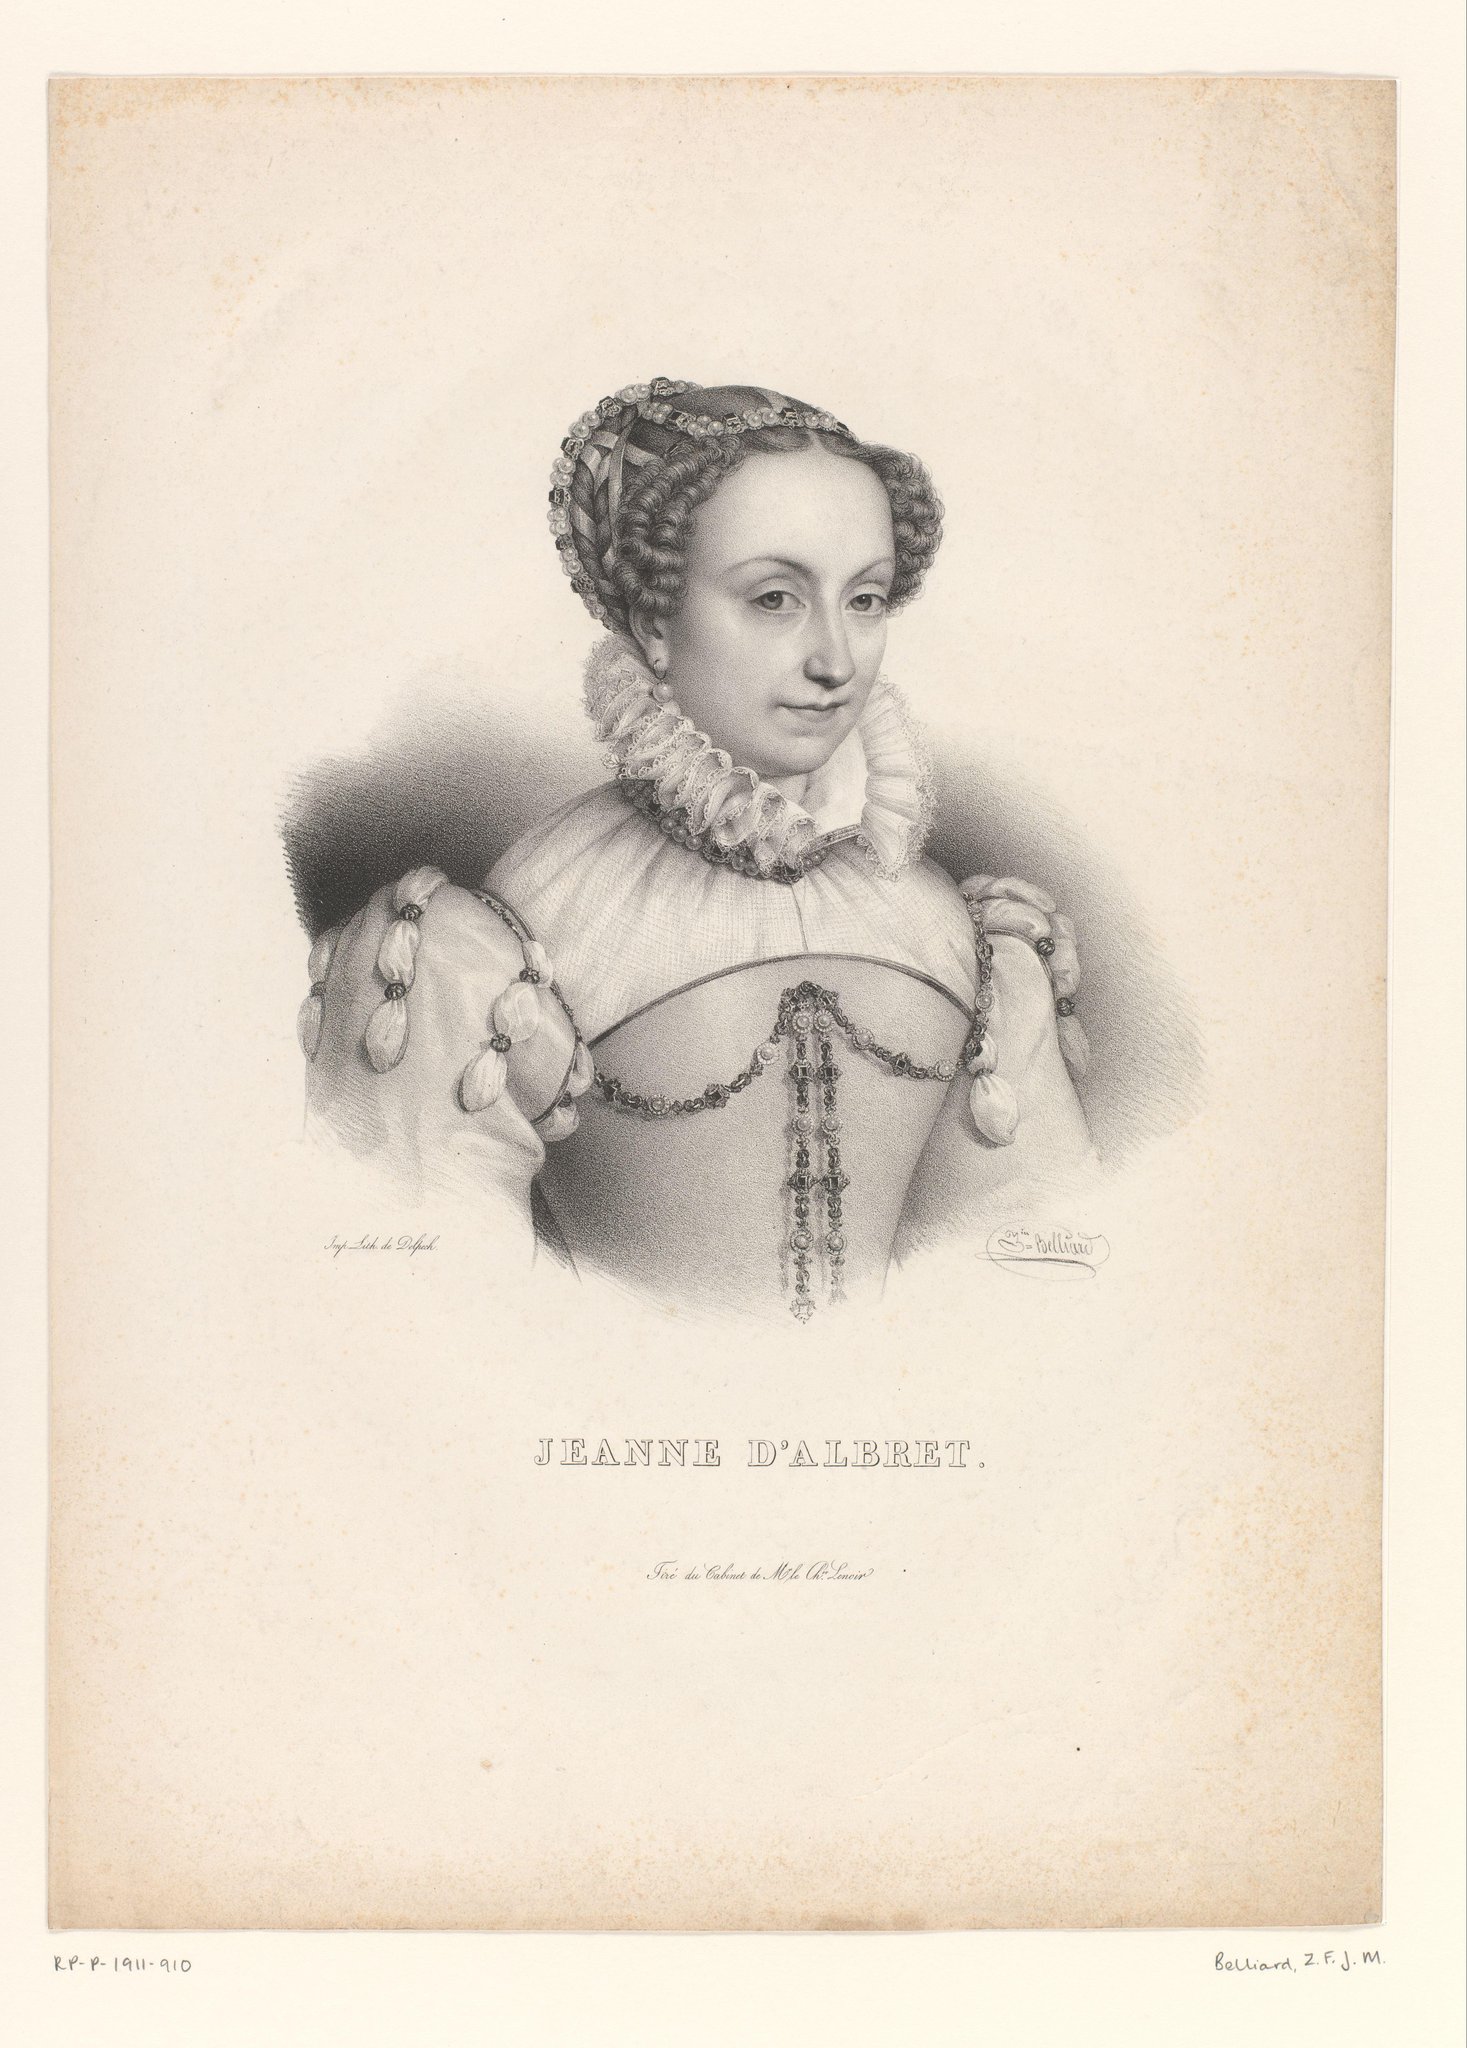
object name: print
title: Tweehonderd portretten tussen de regeringsperioden van Karel VII en Lodewijk XVI van Frankrijk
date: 1828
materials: paper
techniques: lithograph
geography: paris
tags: paris, historical persons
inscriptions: collector's mark: Lugt 2228a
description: Prent gepubliceerd in: Iconographie française, ou Choix de deux cents portraits d'hommes et de femmes depuis le règne de Charles VII jusqu'à la fin de celui de Louis XVI, publié par Madame Delpech, Parijs 1840.